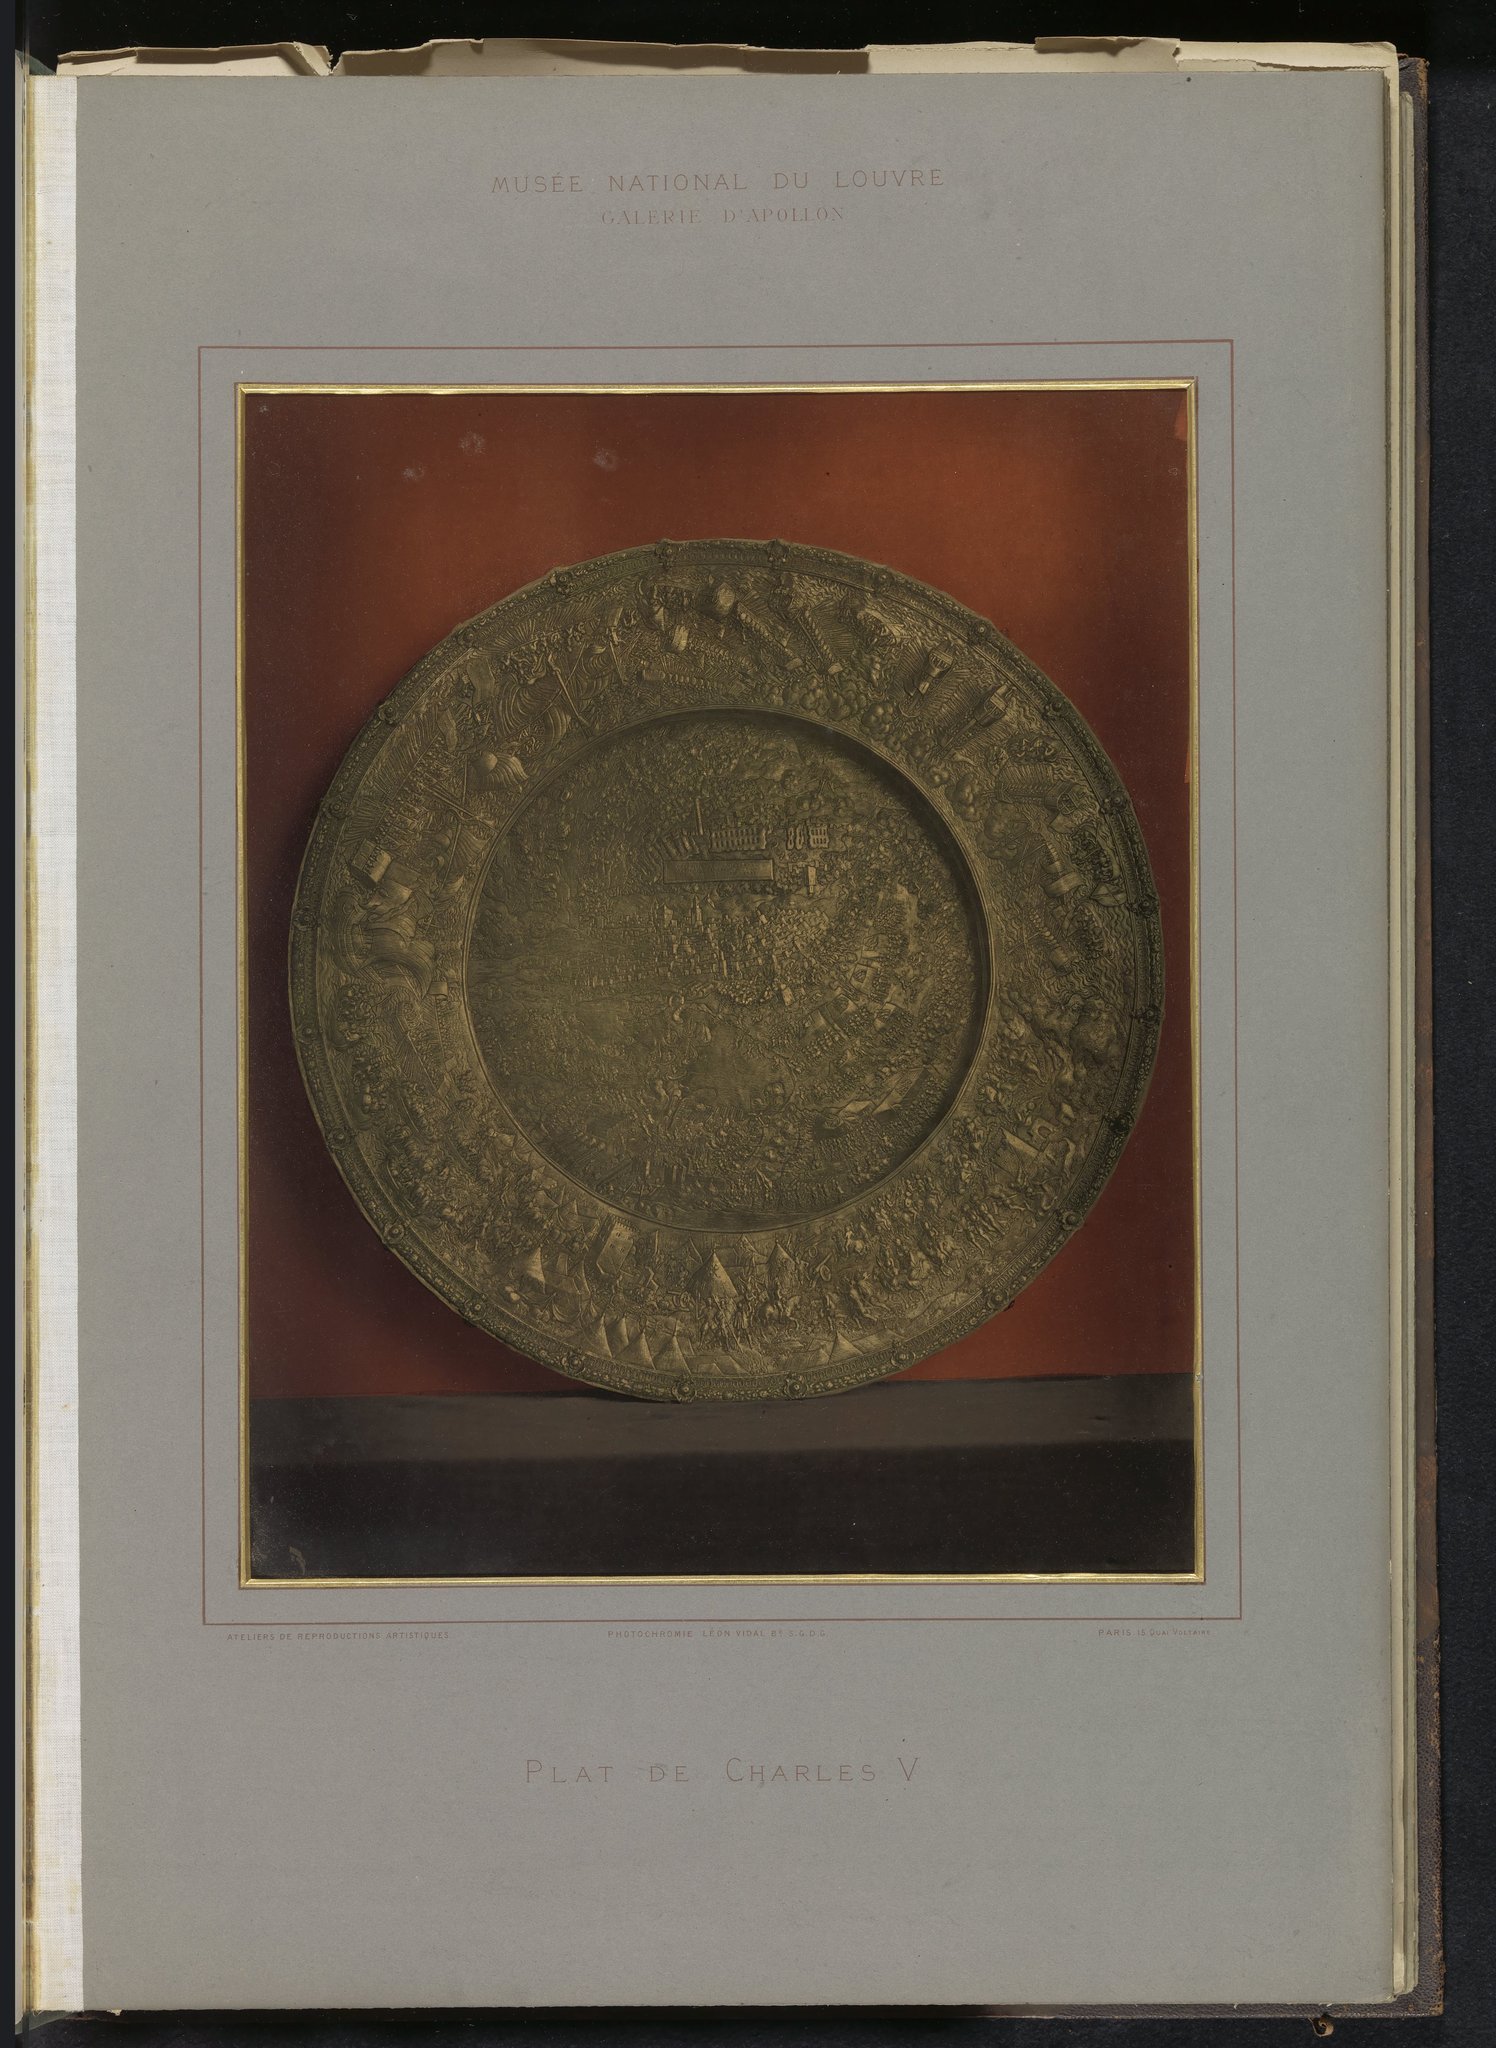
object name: page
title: Plat de Charles V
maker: léon vidal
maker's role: fotograaf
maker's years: 1833-1906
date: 1876-1883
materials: paper, photographic process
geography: paris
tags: chasing, embossing (industrial process), dish, plate, saucer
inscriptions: inscription: ‘ateliers de reproductions artistiques’